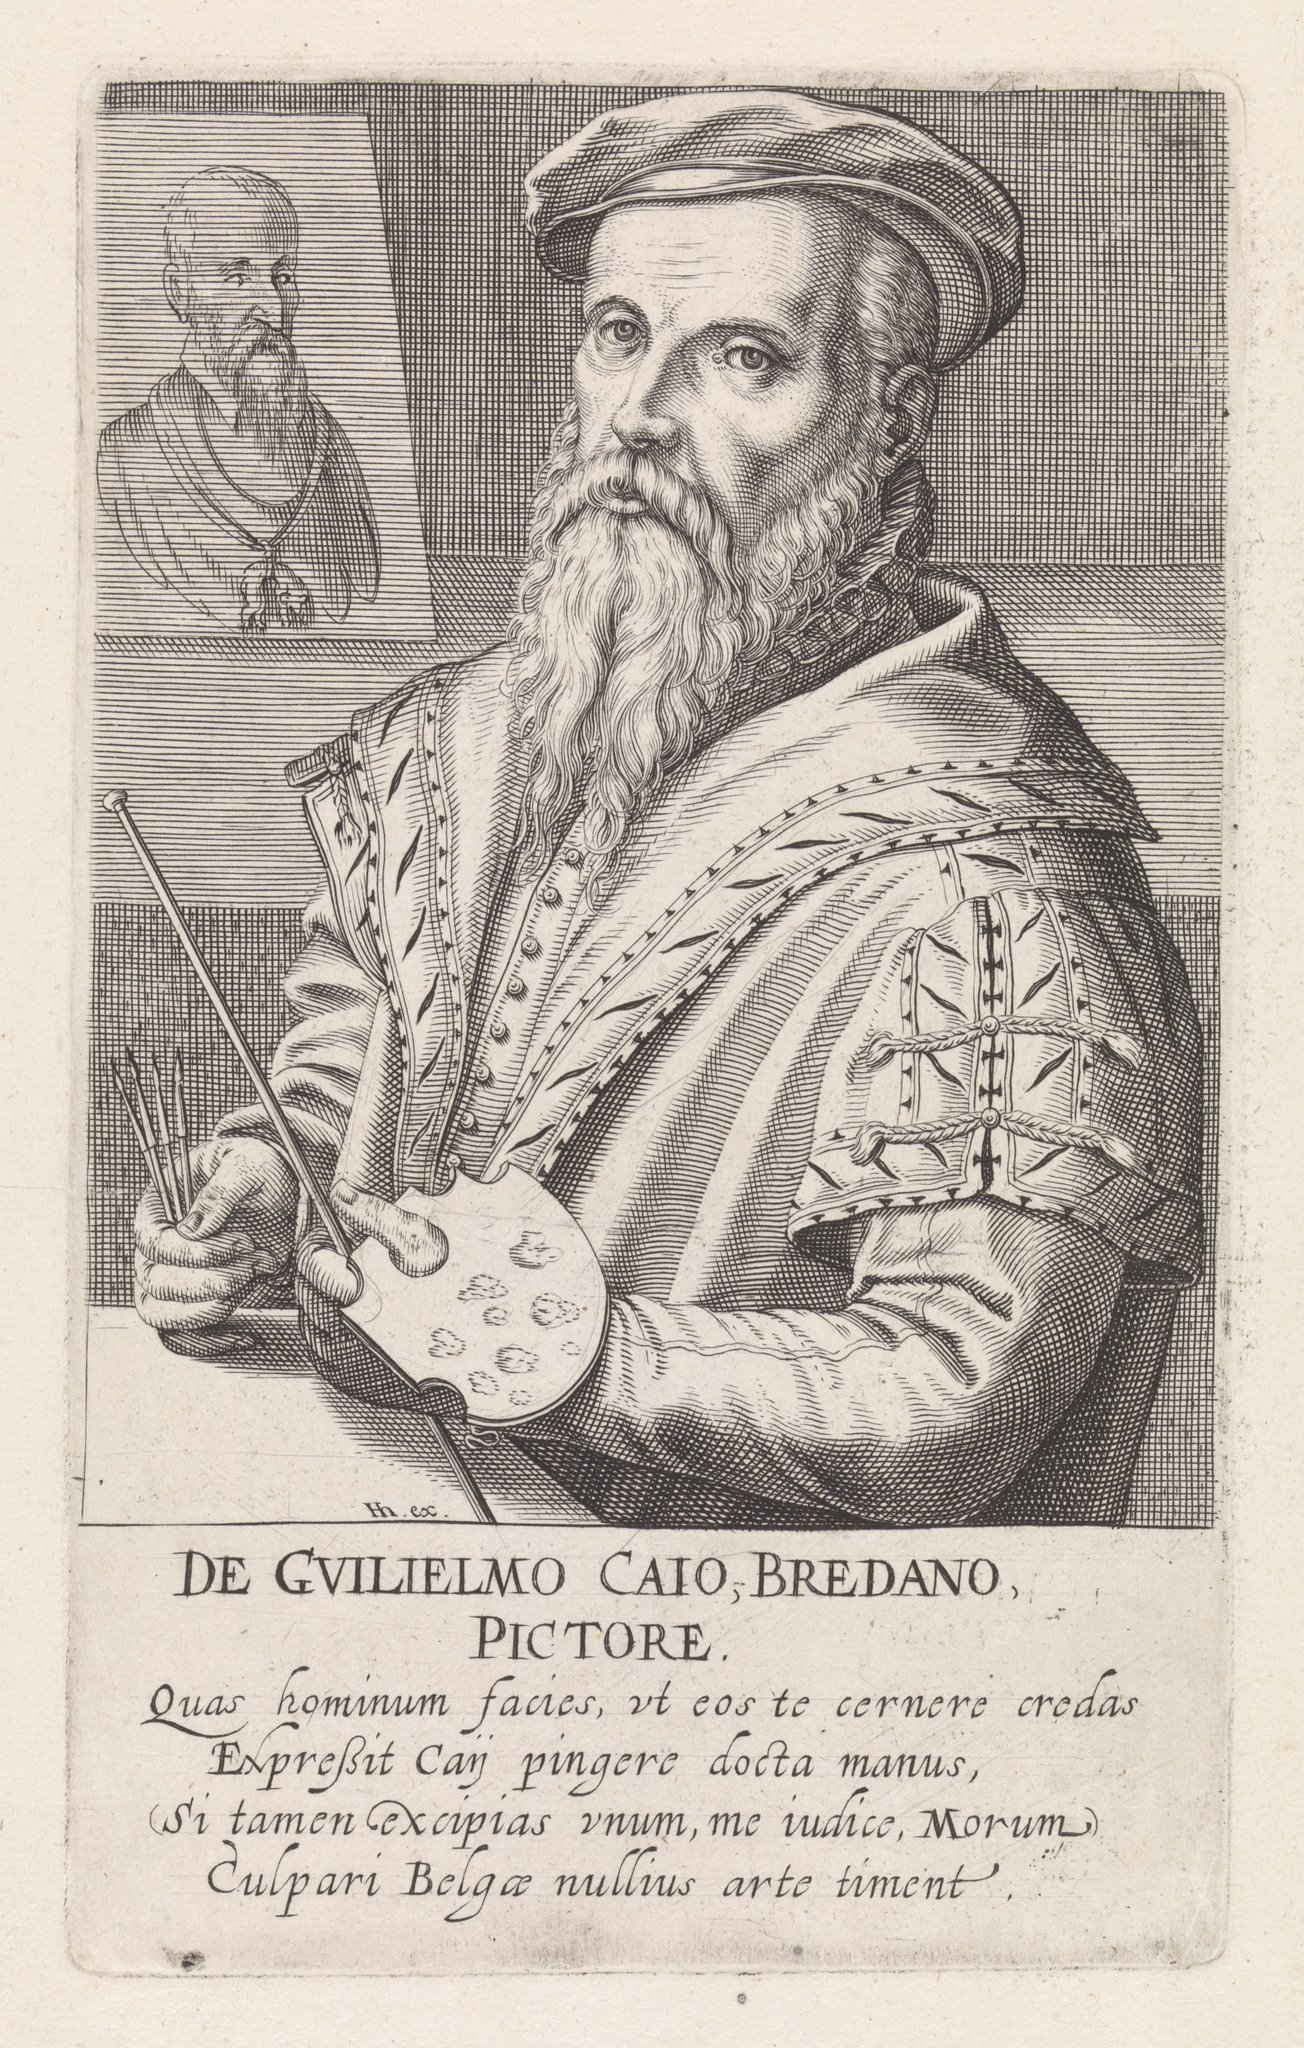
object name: print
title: Portret van Willem Key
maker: hendrick hondius (i)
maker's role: draughtsman, print maker, publisher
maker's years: 1573-1650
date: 1610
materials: paper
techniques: engraving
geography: the hague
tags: antwerp, painter, willem key, portrait, self-portrait of painter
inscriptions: collector's mark: Lugt 2228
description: Portret ten halven lijve naar links van Willem Key. Onder het portret zijn naam en vier regels in het Latijn. Prent uit deel 1 van de serie Pictorum Aliquot Celebrium Praecipuae Germaniae Inferioris Effigies. Serie van 72 kunstenaarsportretten vervaardigd door Hendrick Hondius I, Simon Frisius, Andries Jacobsz. Stock en Robert de Baudous.